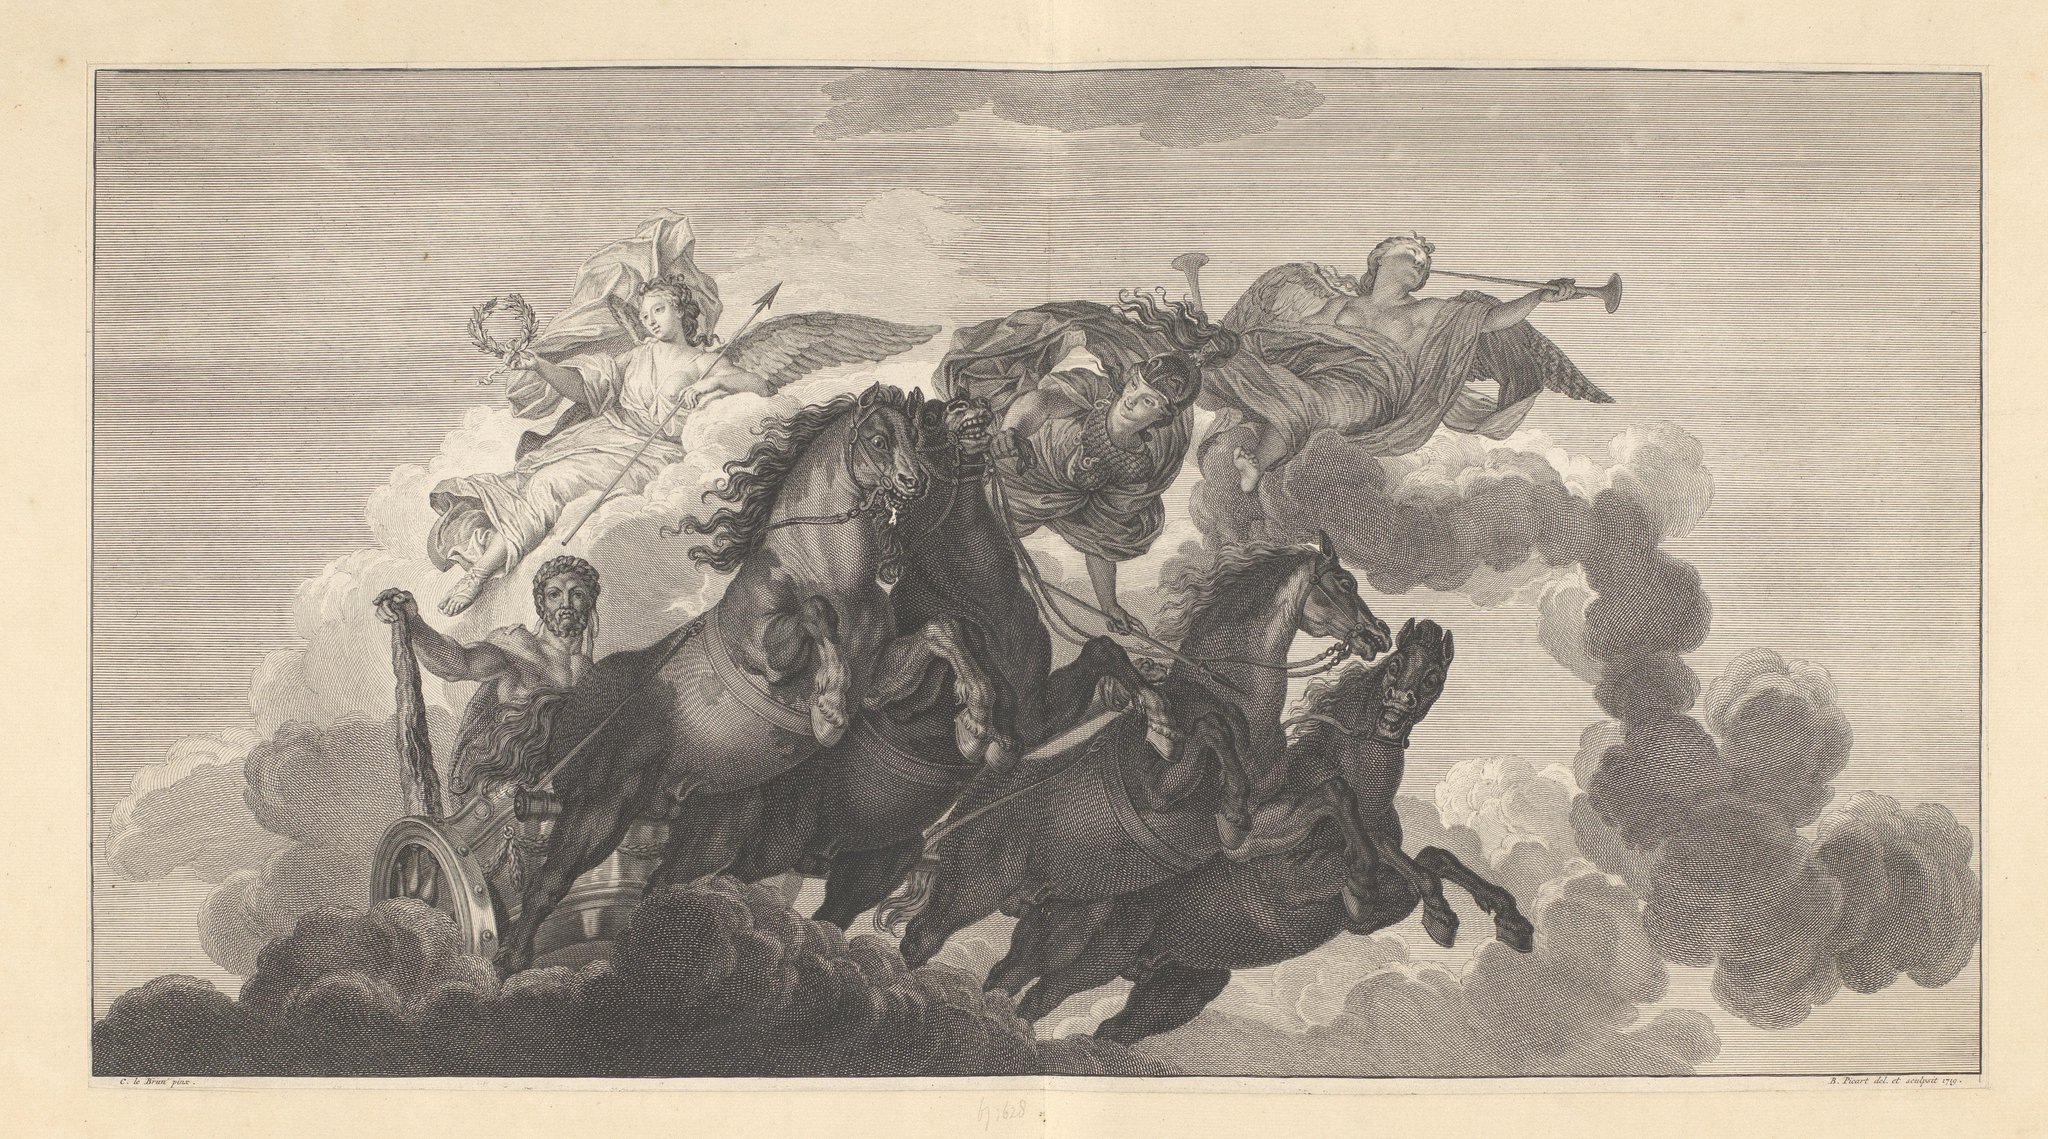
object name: print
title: Galerie Lambert: Apotheose van Hercules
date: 1719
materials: paper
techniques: engraving, etching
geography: amsterdam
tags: (decorated) ceiling, apotheosis of hercules: he is borne to heaven in a four-horse chariot and reconciled with juno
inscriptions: date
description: Onder begeleiding van Minerva stijgt Hercules in een wagen, getrokken door vier paarden, op naar de Olympus. Op de wolken zitten Victoria, met een lauwerkrans voor de held, en Faam, die de loftrompet blaast. Prent maakt deel uit van een serie prenten, die samen het geschilderde plafond met de Apotheose van Hercules in het Hôtel Lambert te Parijs voorstellen. Deze prent maakt deel uit van een album.